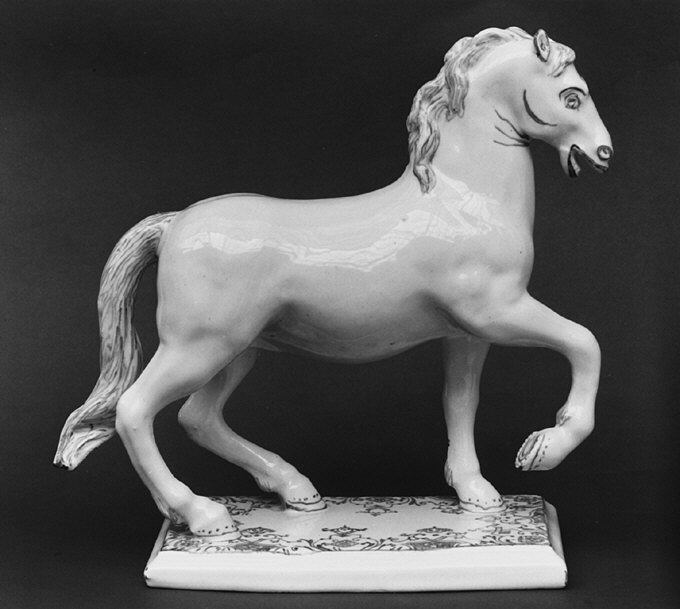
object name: figure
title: Horse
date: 1801-1900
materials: earthenware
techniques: glazing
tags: horses